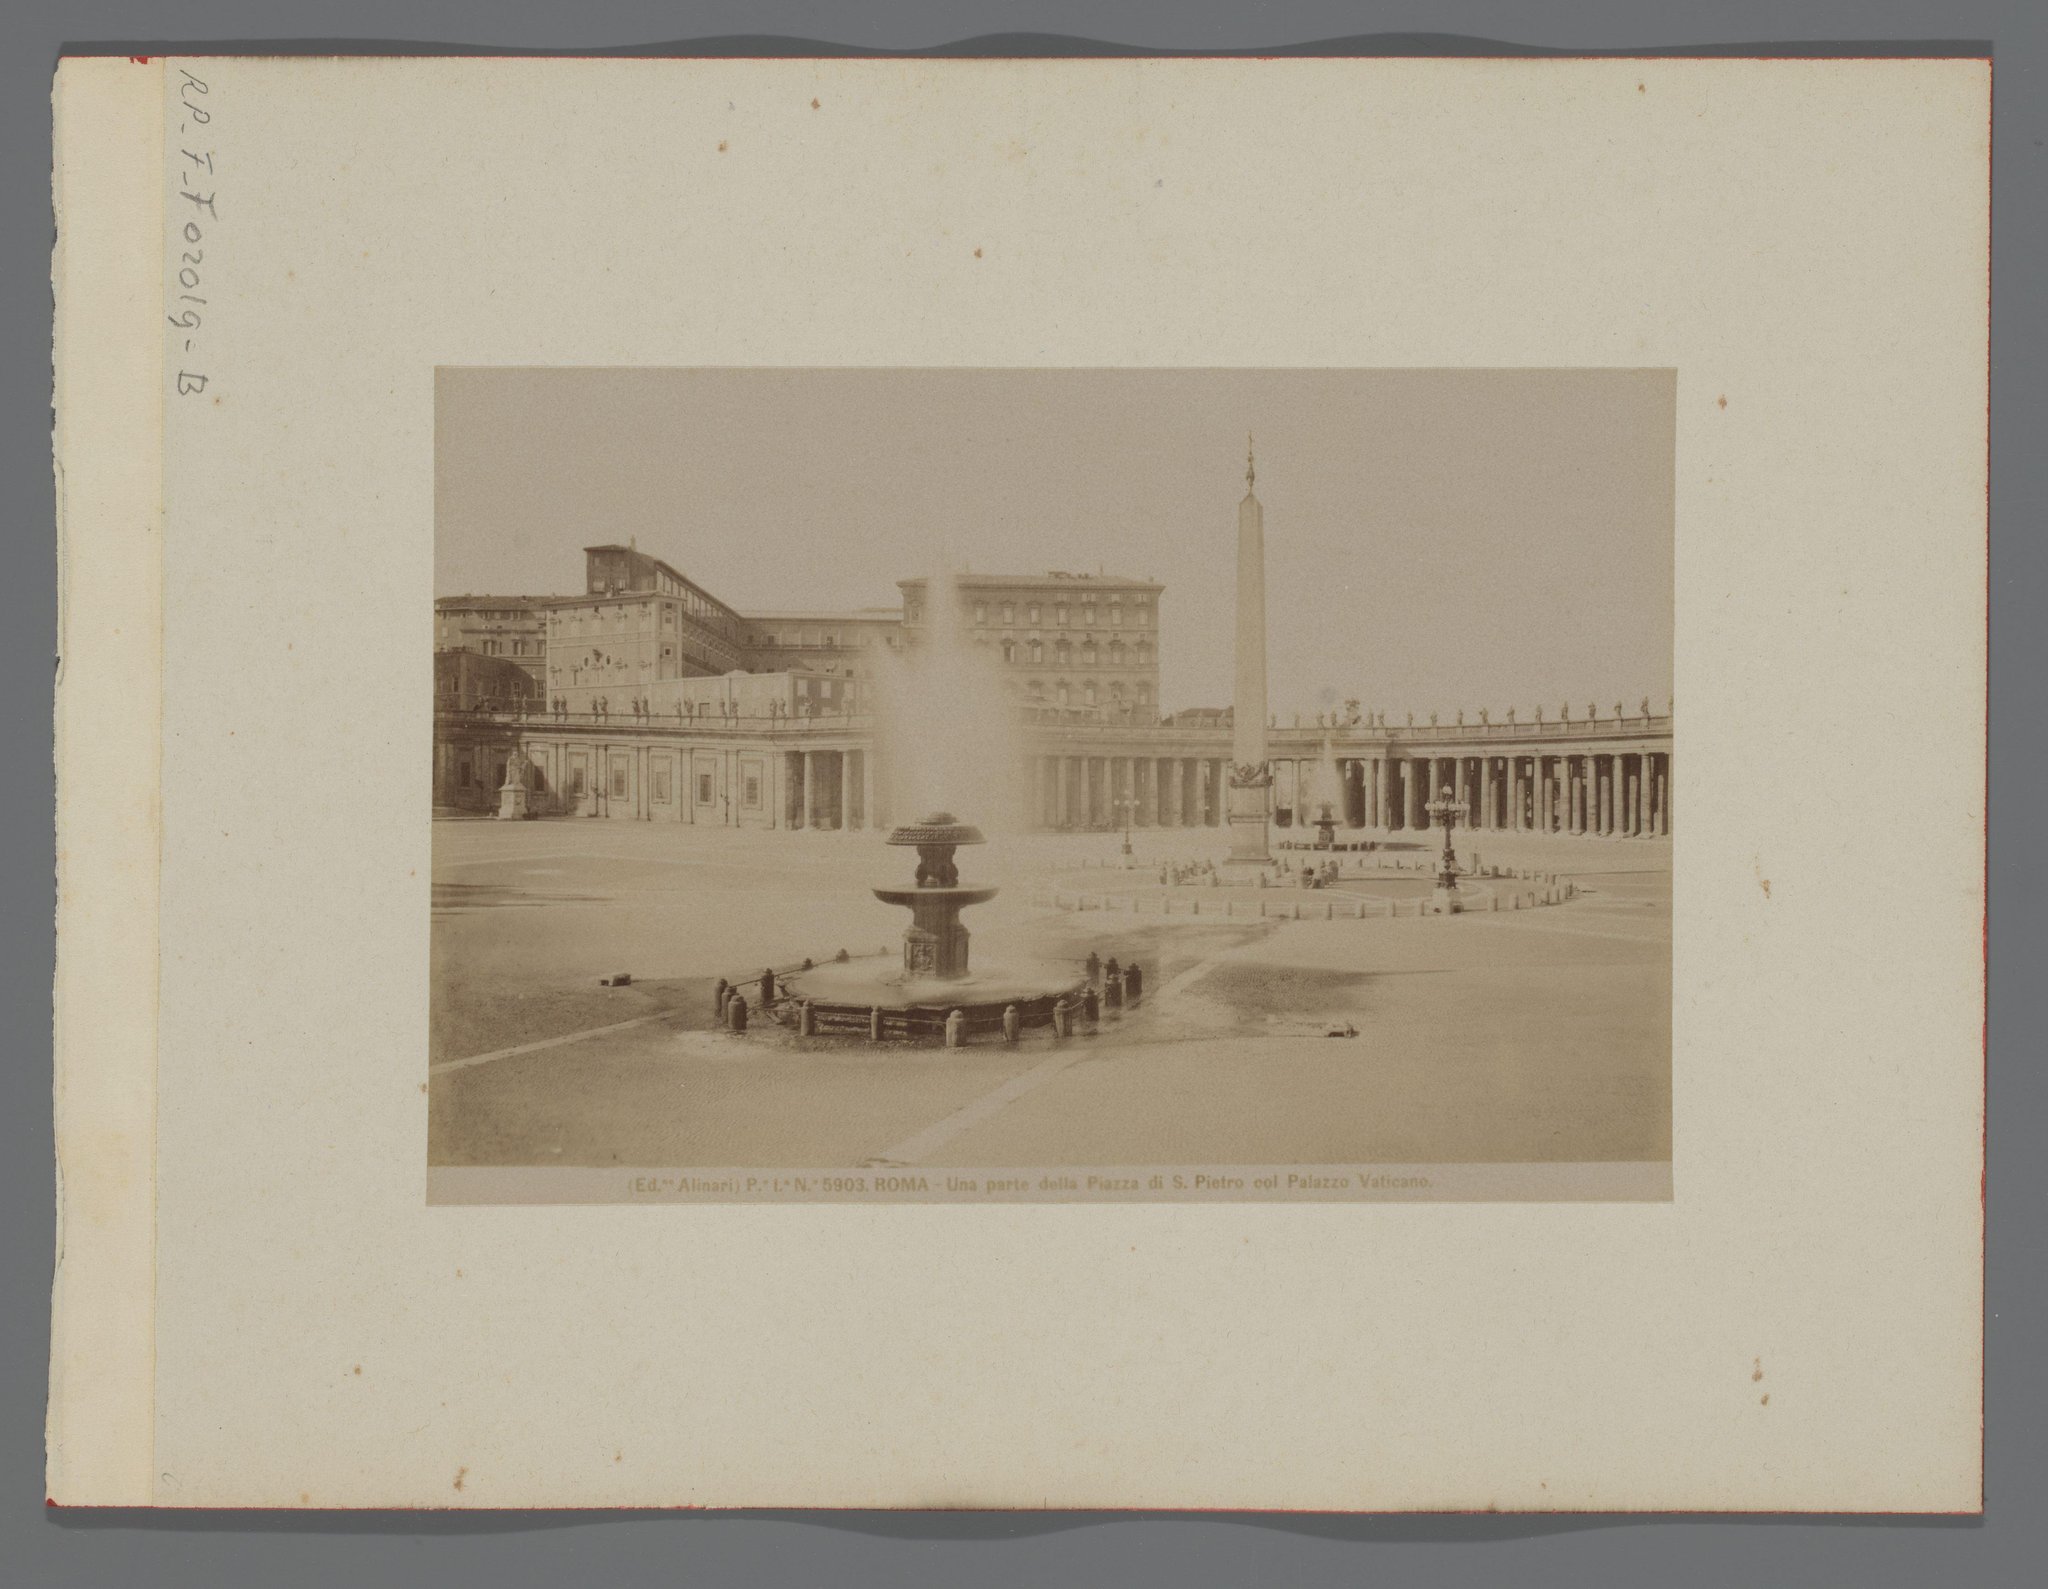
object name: photograph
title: Gezicht op het Sint Pietersplein met de obelisk te Vaticaanstad, Italië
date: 1852-1900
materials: cardboard, paper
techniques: albumen print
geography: vatican city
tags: square, place, circus, etc., obelisk, needle, ornamental fountain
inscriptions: number: ‘Po. Io. No. 5903.’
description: Op de achtergrond zijn de colonnades van Giovanni Lorenzo Bernini te zien.